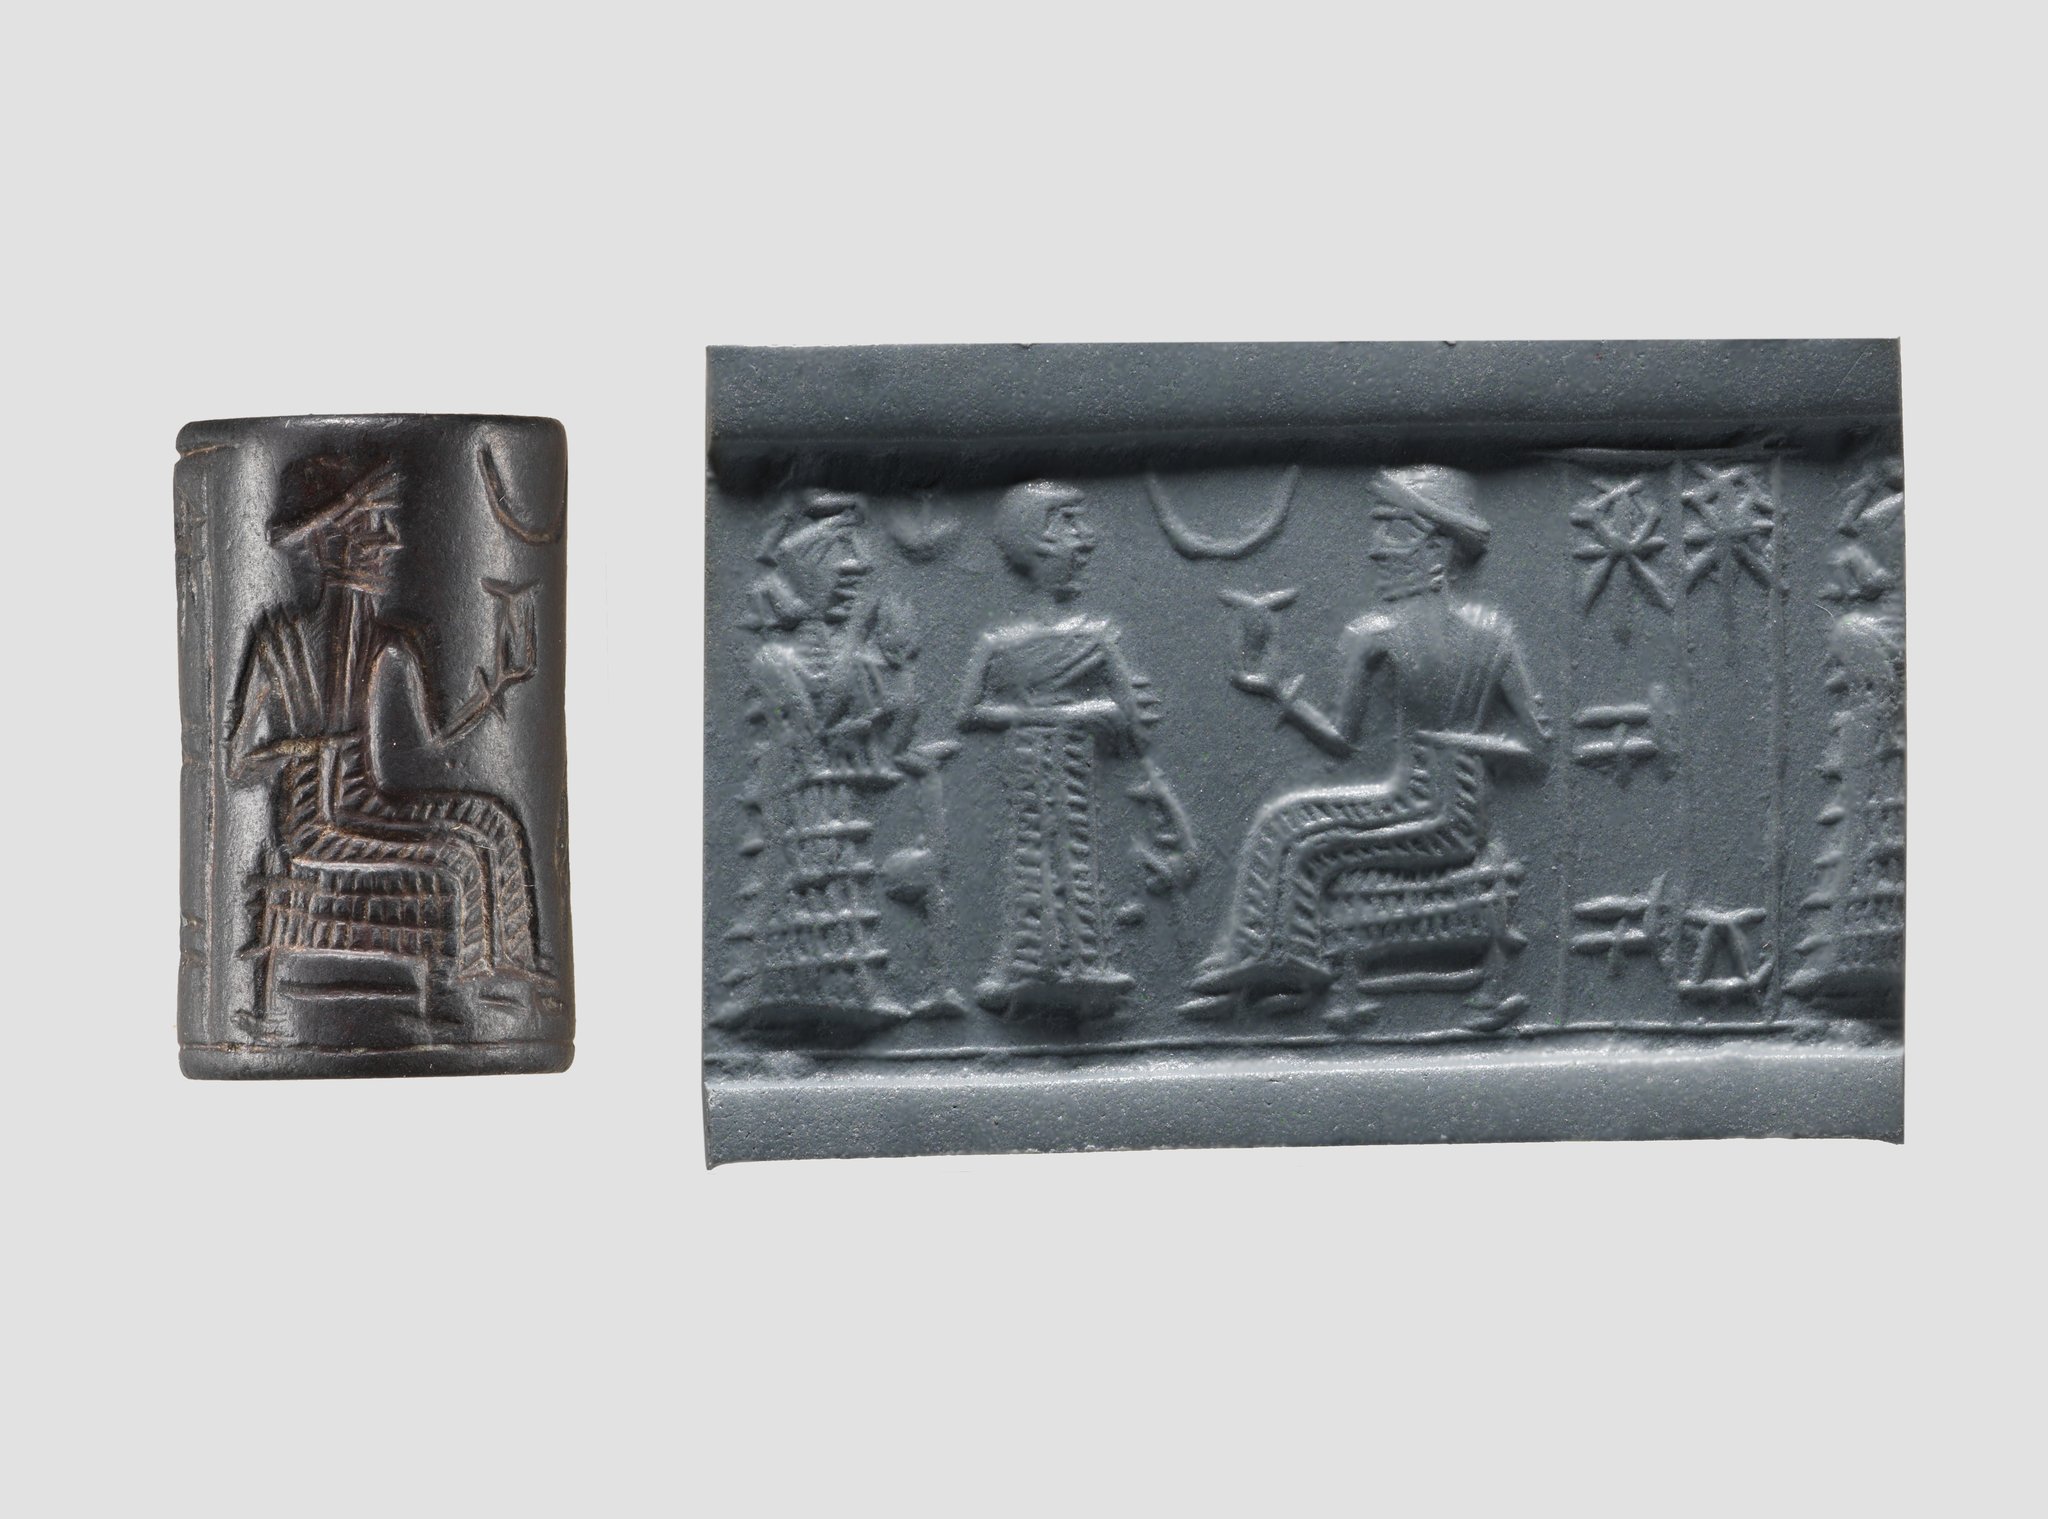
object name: cylinder seal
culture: isin-larsa–old babylonian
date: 2000-1668 BCE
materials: mineral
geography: mesopotamia